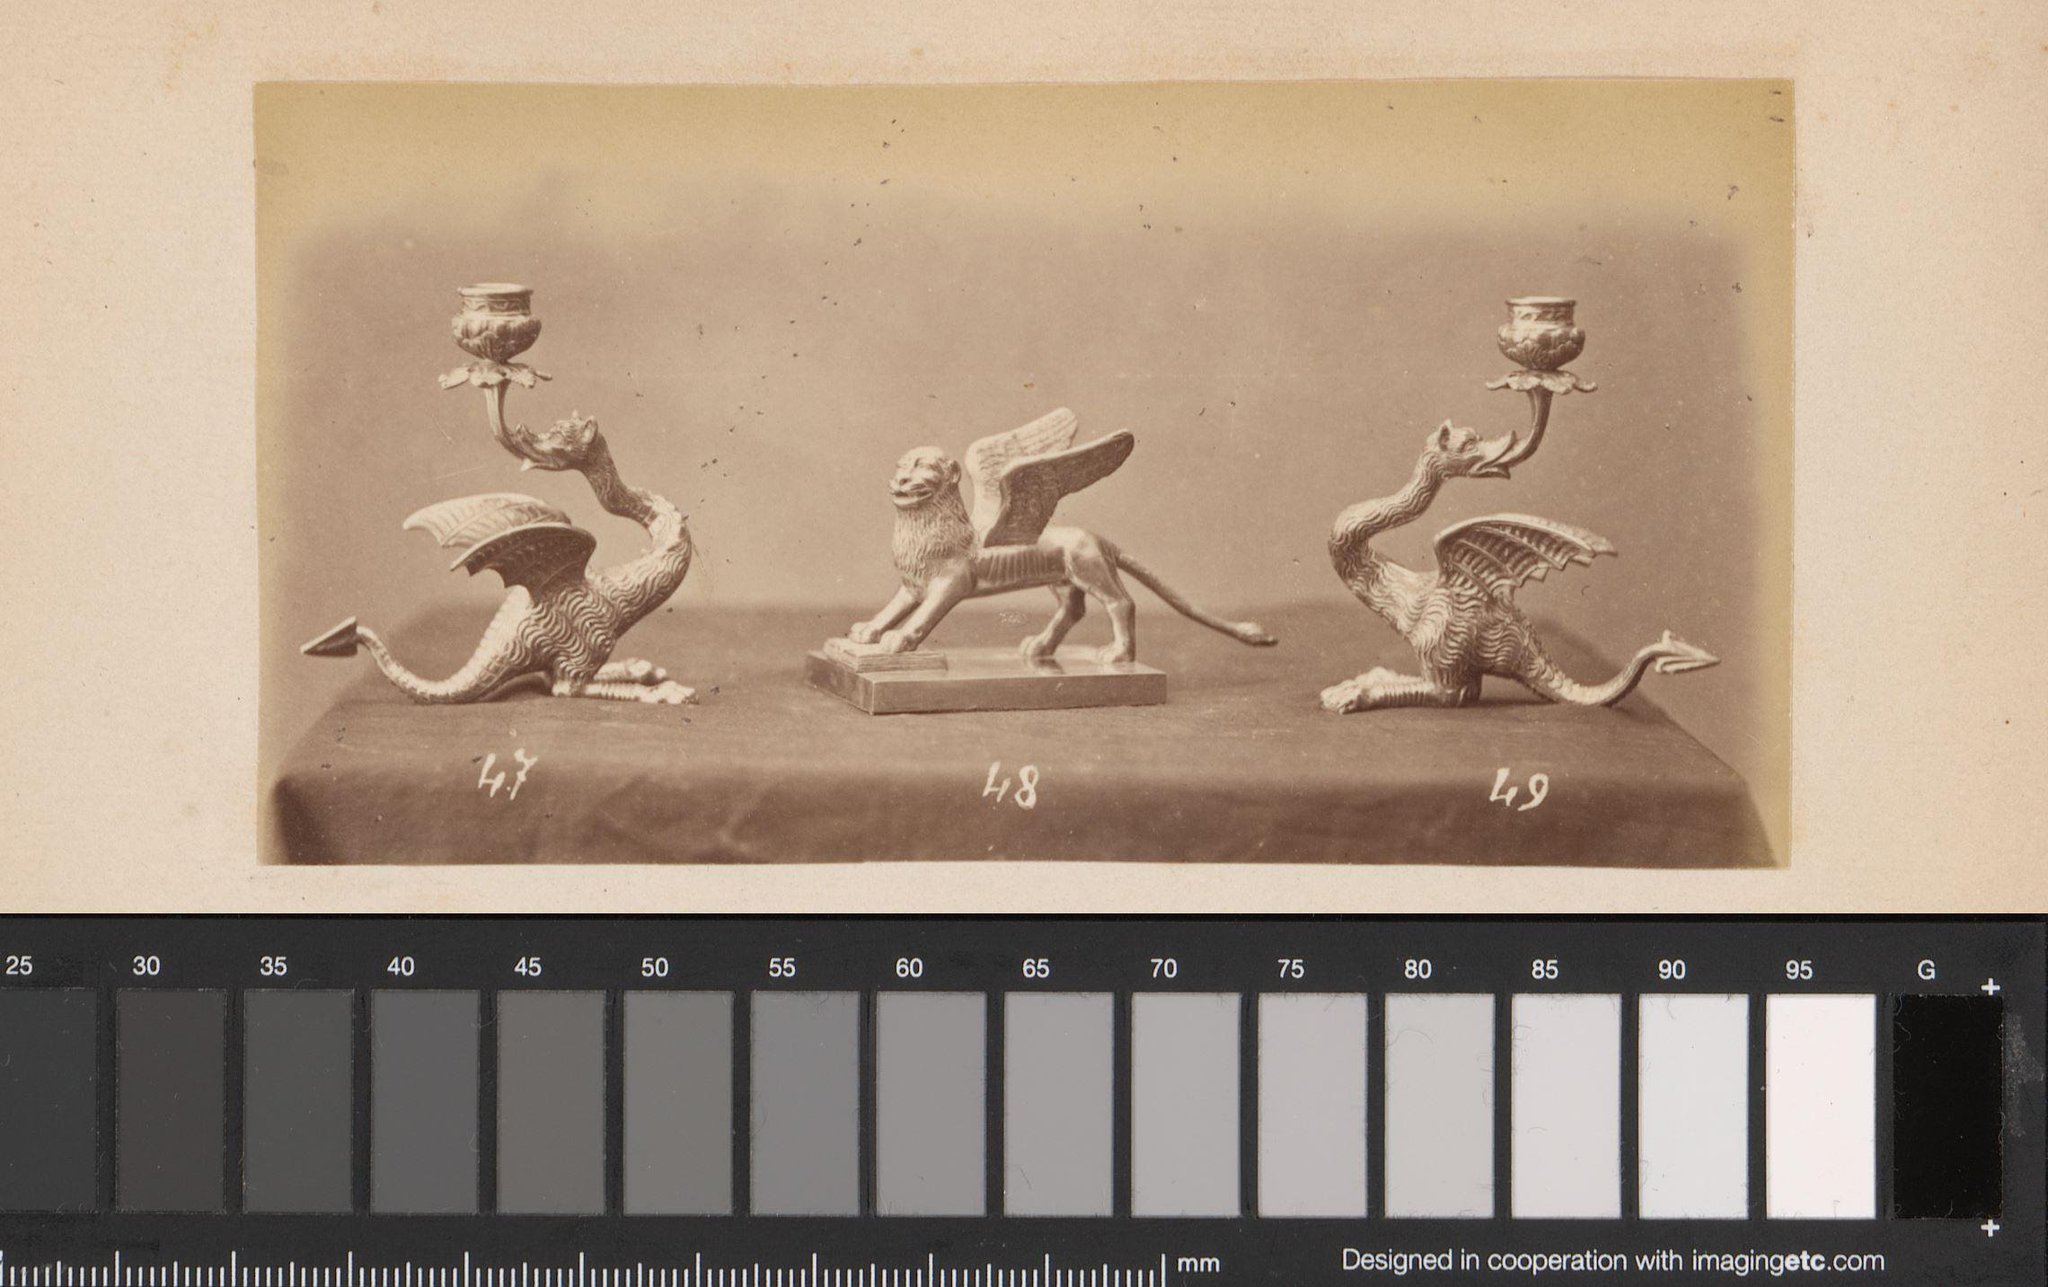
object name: page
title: Metalen kandelaars in de vorm van griffioenen en leeuw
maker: Anonymous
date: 1860-1885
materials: photographic support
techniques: albumen print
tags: griffin (lion/eagle); 'griffo' (ripa), candlestick